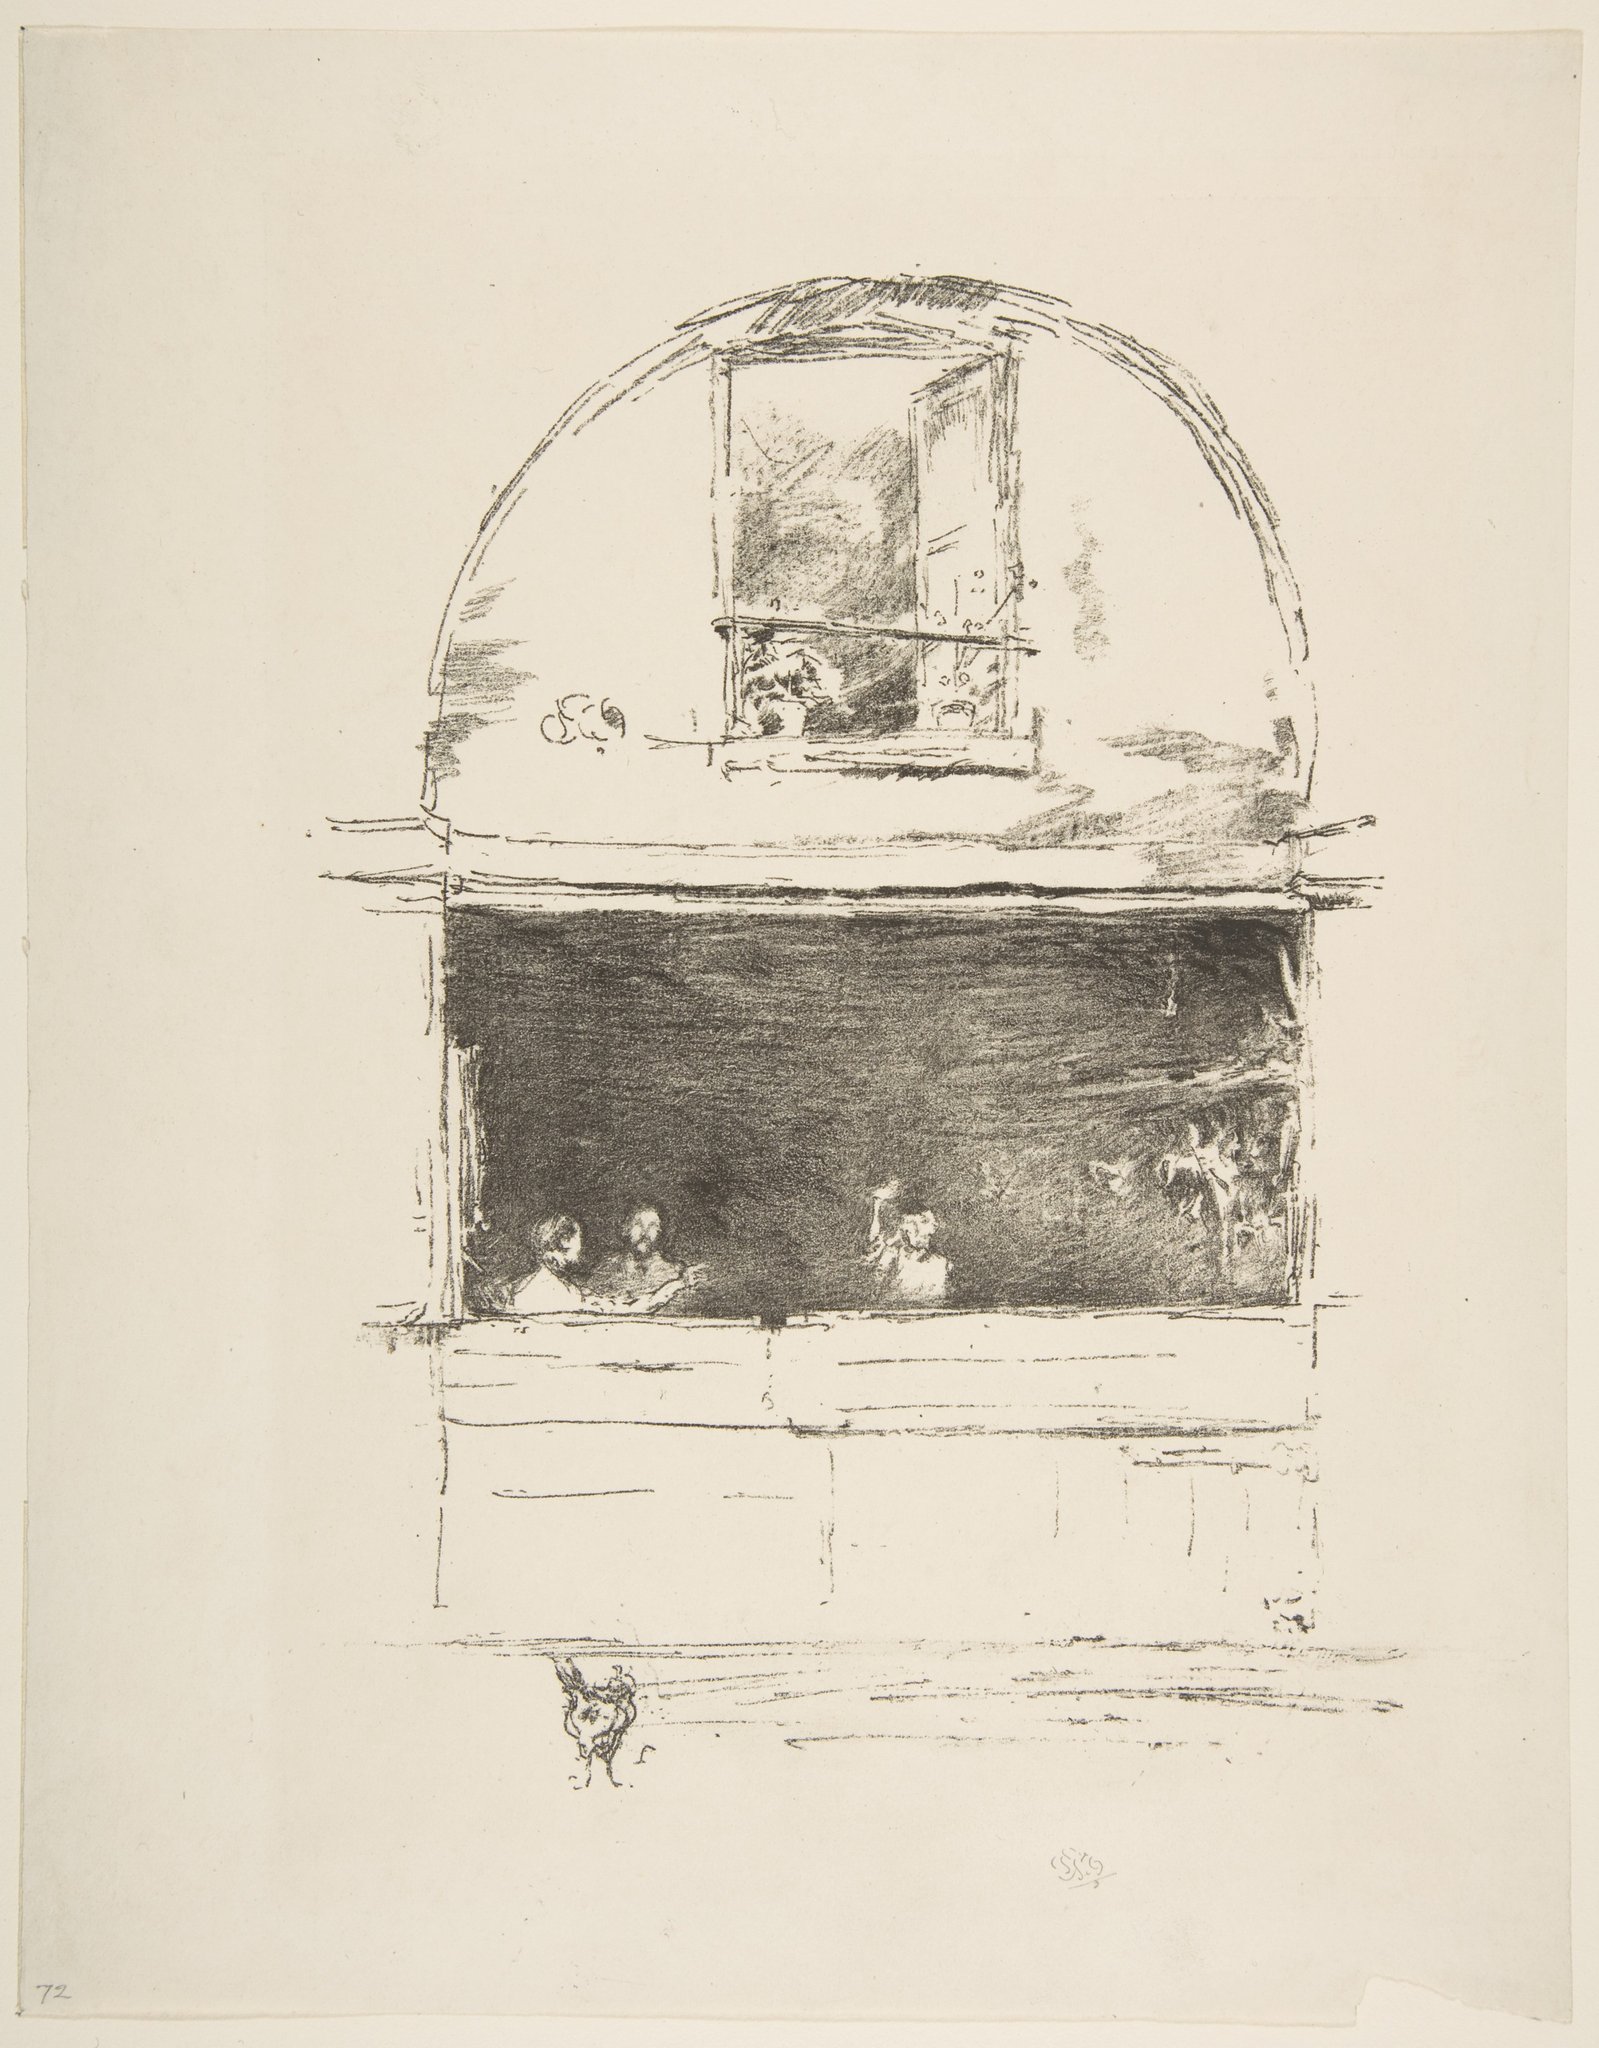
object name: print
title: The Forge, Passage du Dragon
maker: james mcneill whistler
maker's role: artist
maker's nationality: american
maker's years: 1834-1903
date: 1894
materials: ink, paper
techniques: printing, stumping, lithography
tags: windows